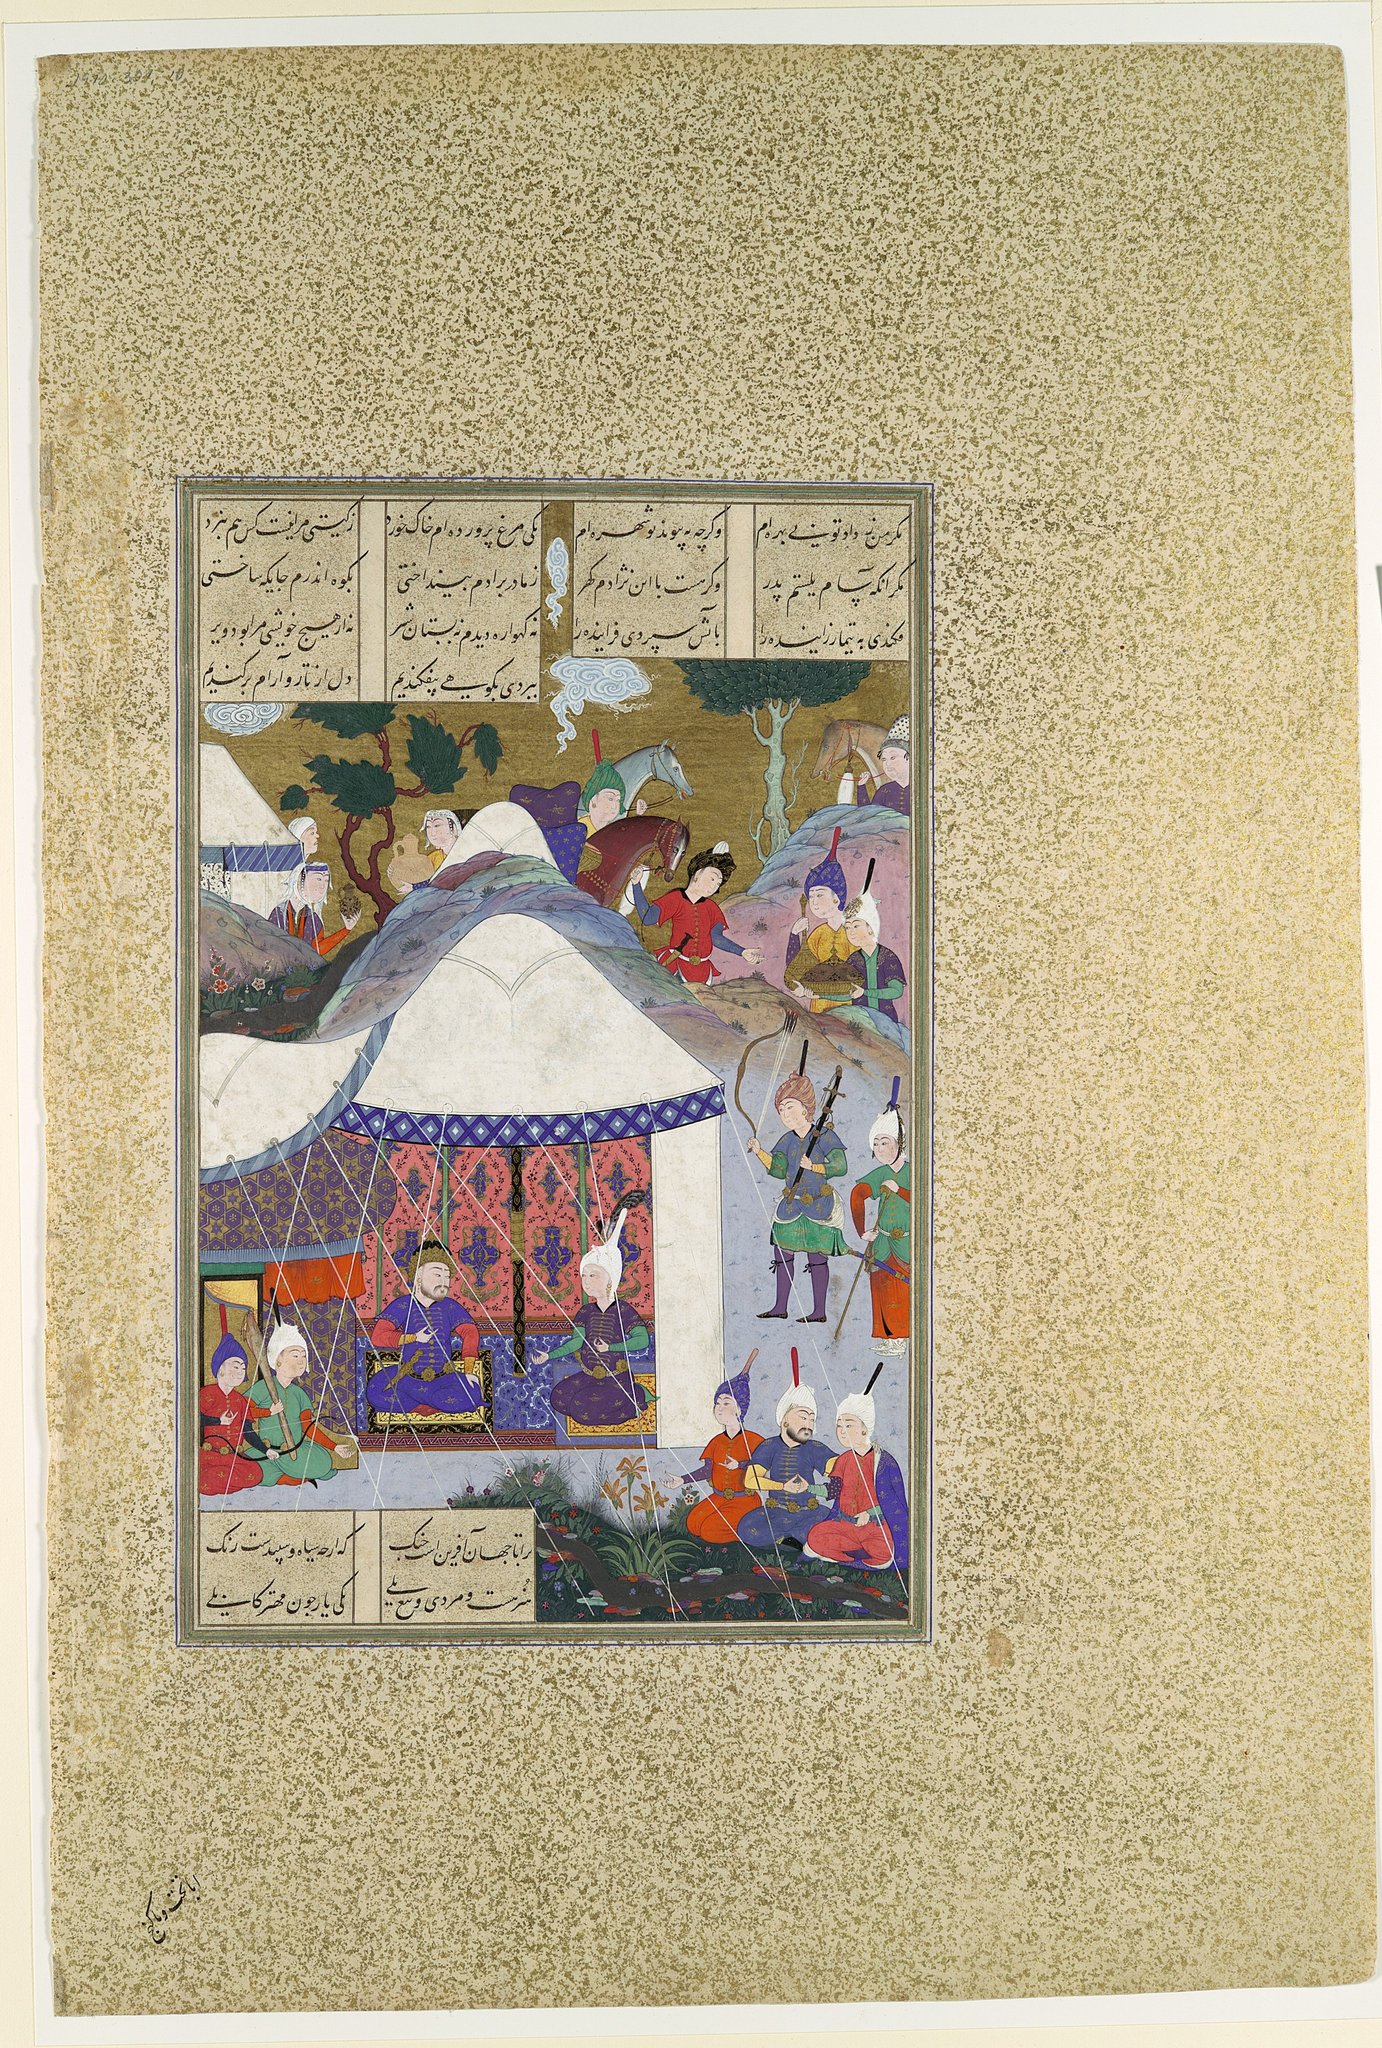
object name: folio from an illustrated manuscript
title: "Zal Questions Sam's Intentions Regarding the House of Mihrab", Folio 81v from the Shahnama (Book of Kings) of Shah Tahmasp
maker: abu'l qasim firdausi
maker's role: author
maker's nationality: iranian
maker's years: 935-1020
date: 1525-1530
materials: gold, ink, paper, silver, watercolor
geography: iran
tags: tents,men,horses